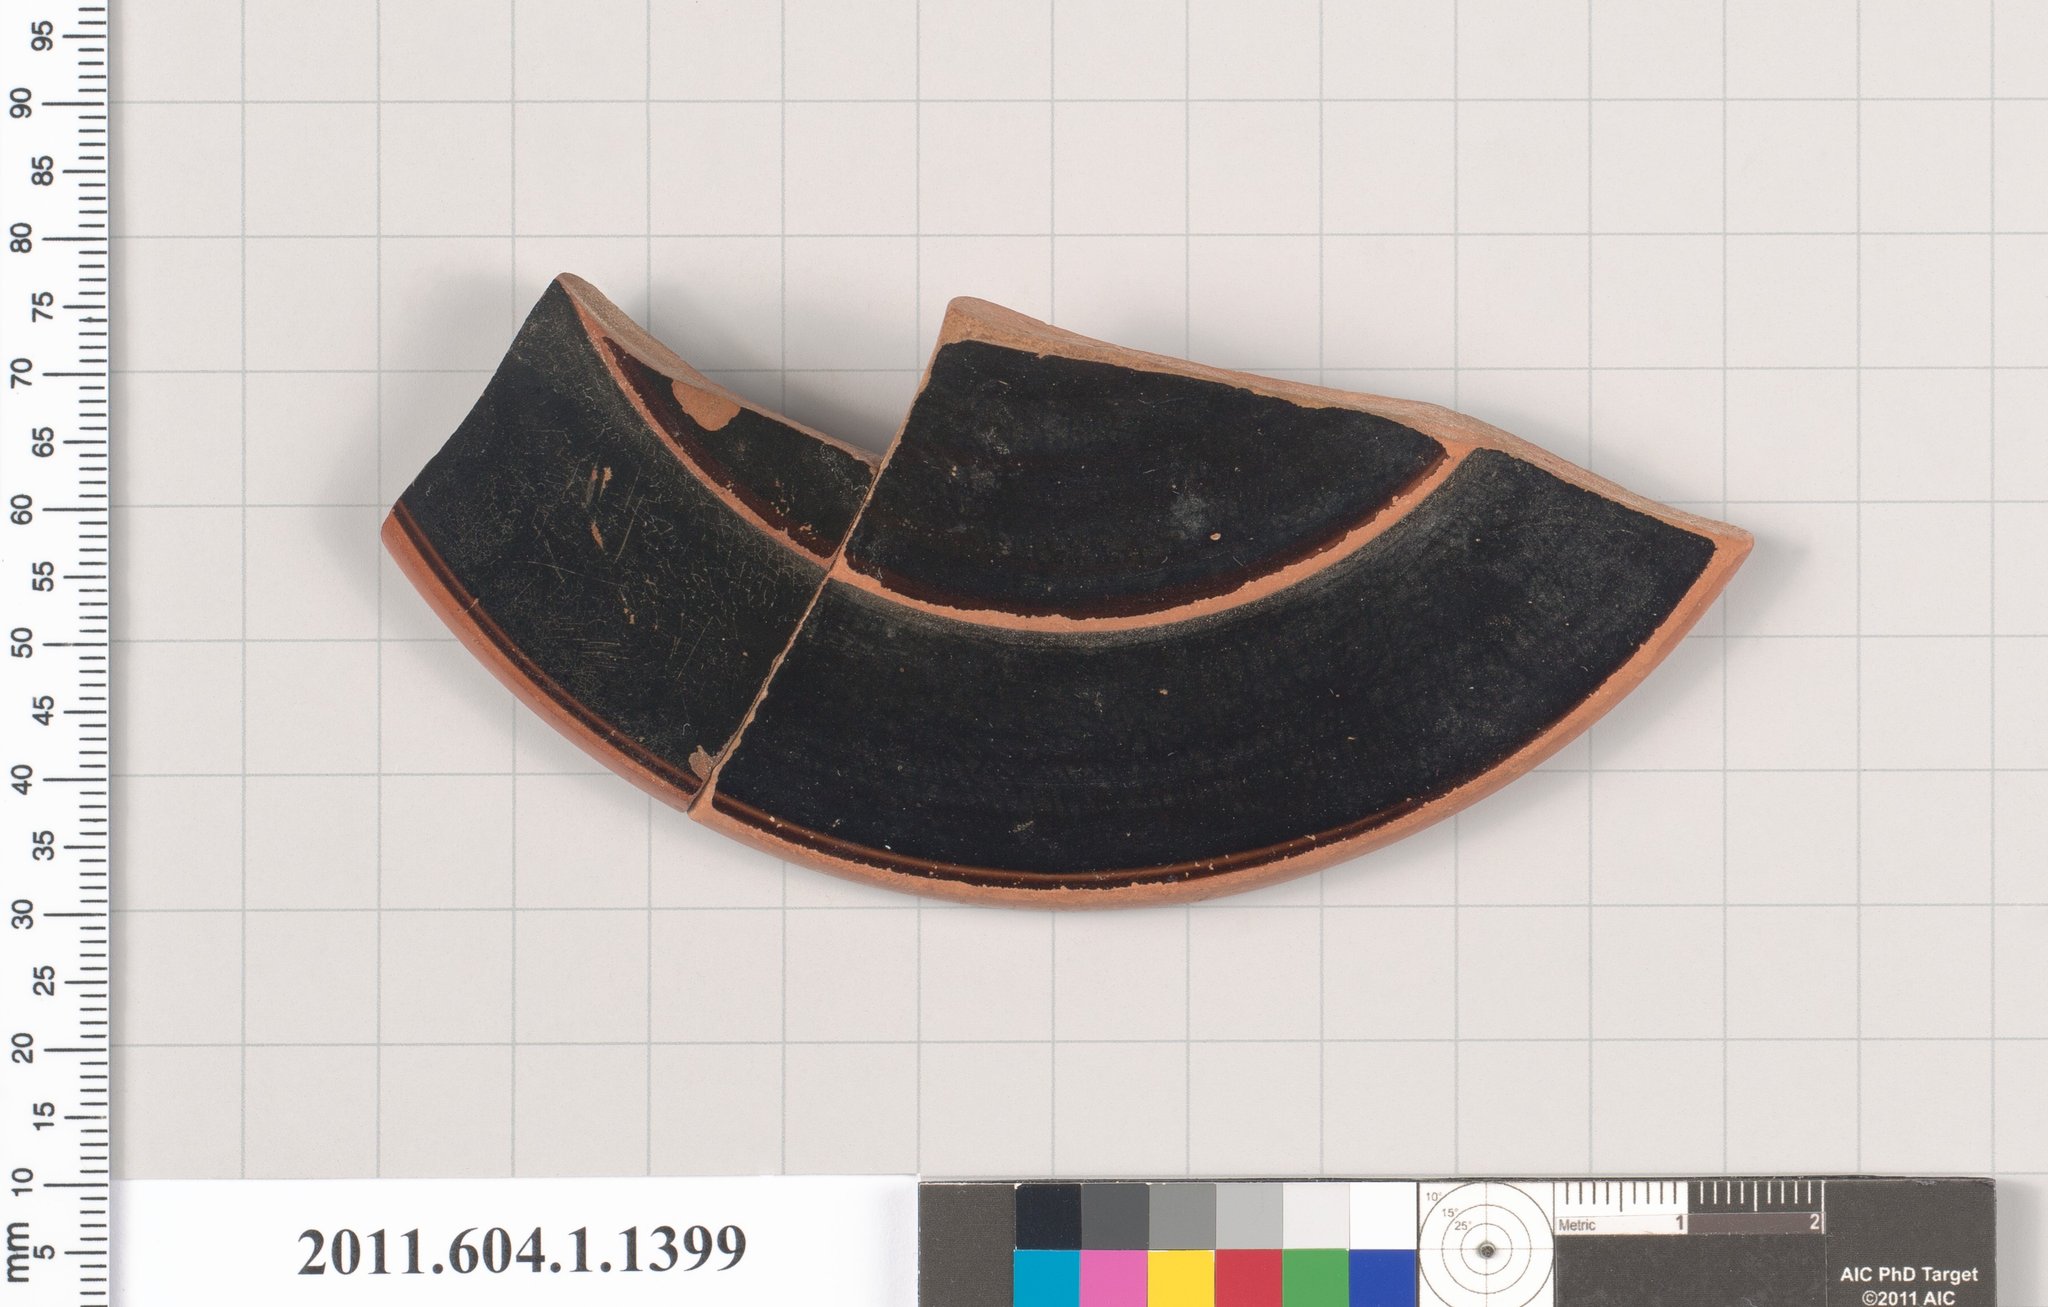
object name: kylix fragment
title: Terracotta fragment of a kylix (drinking cup)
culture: greek, attic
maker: onesimos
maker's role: artist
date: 500-476 BCE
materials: terracotta